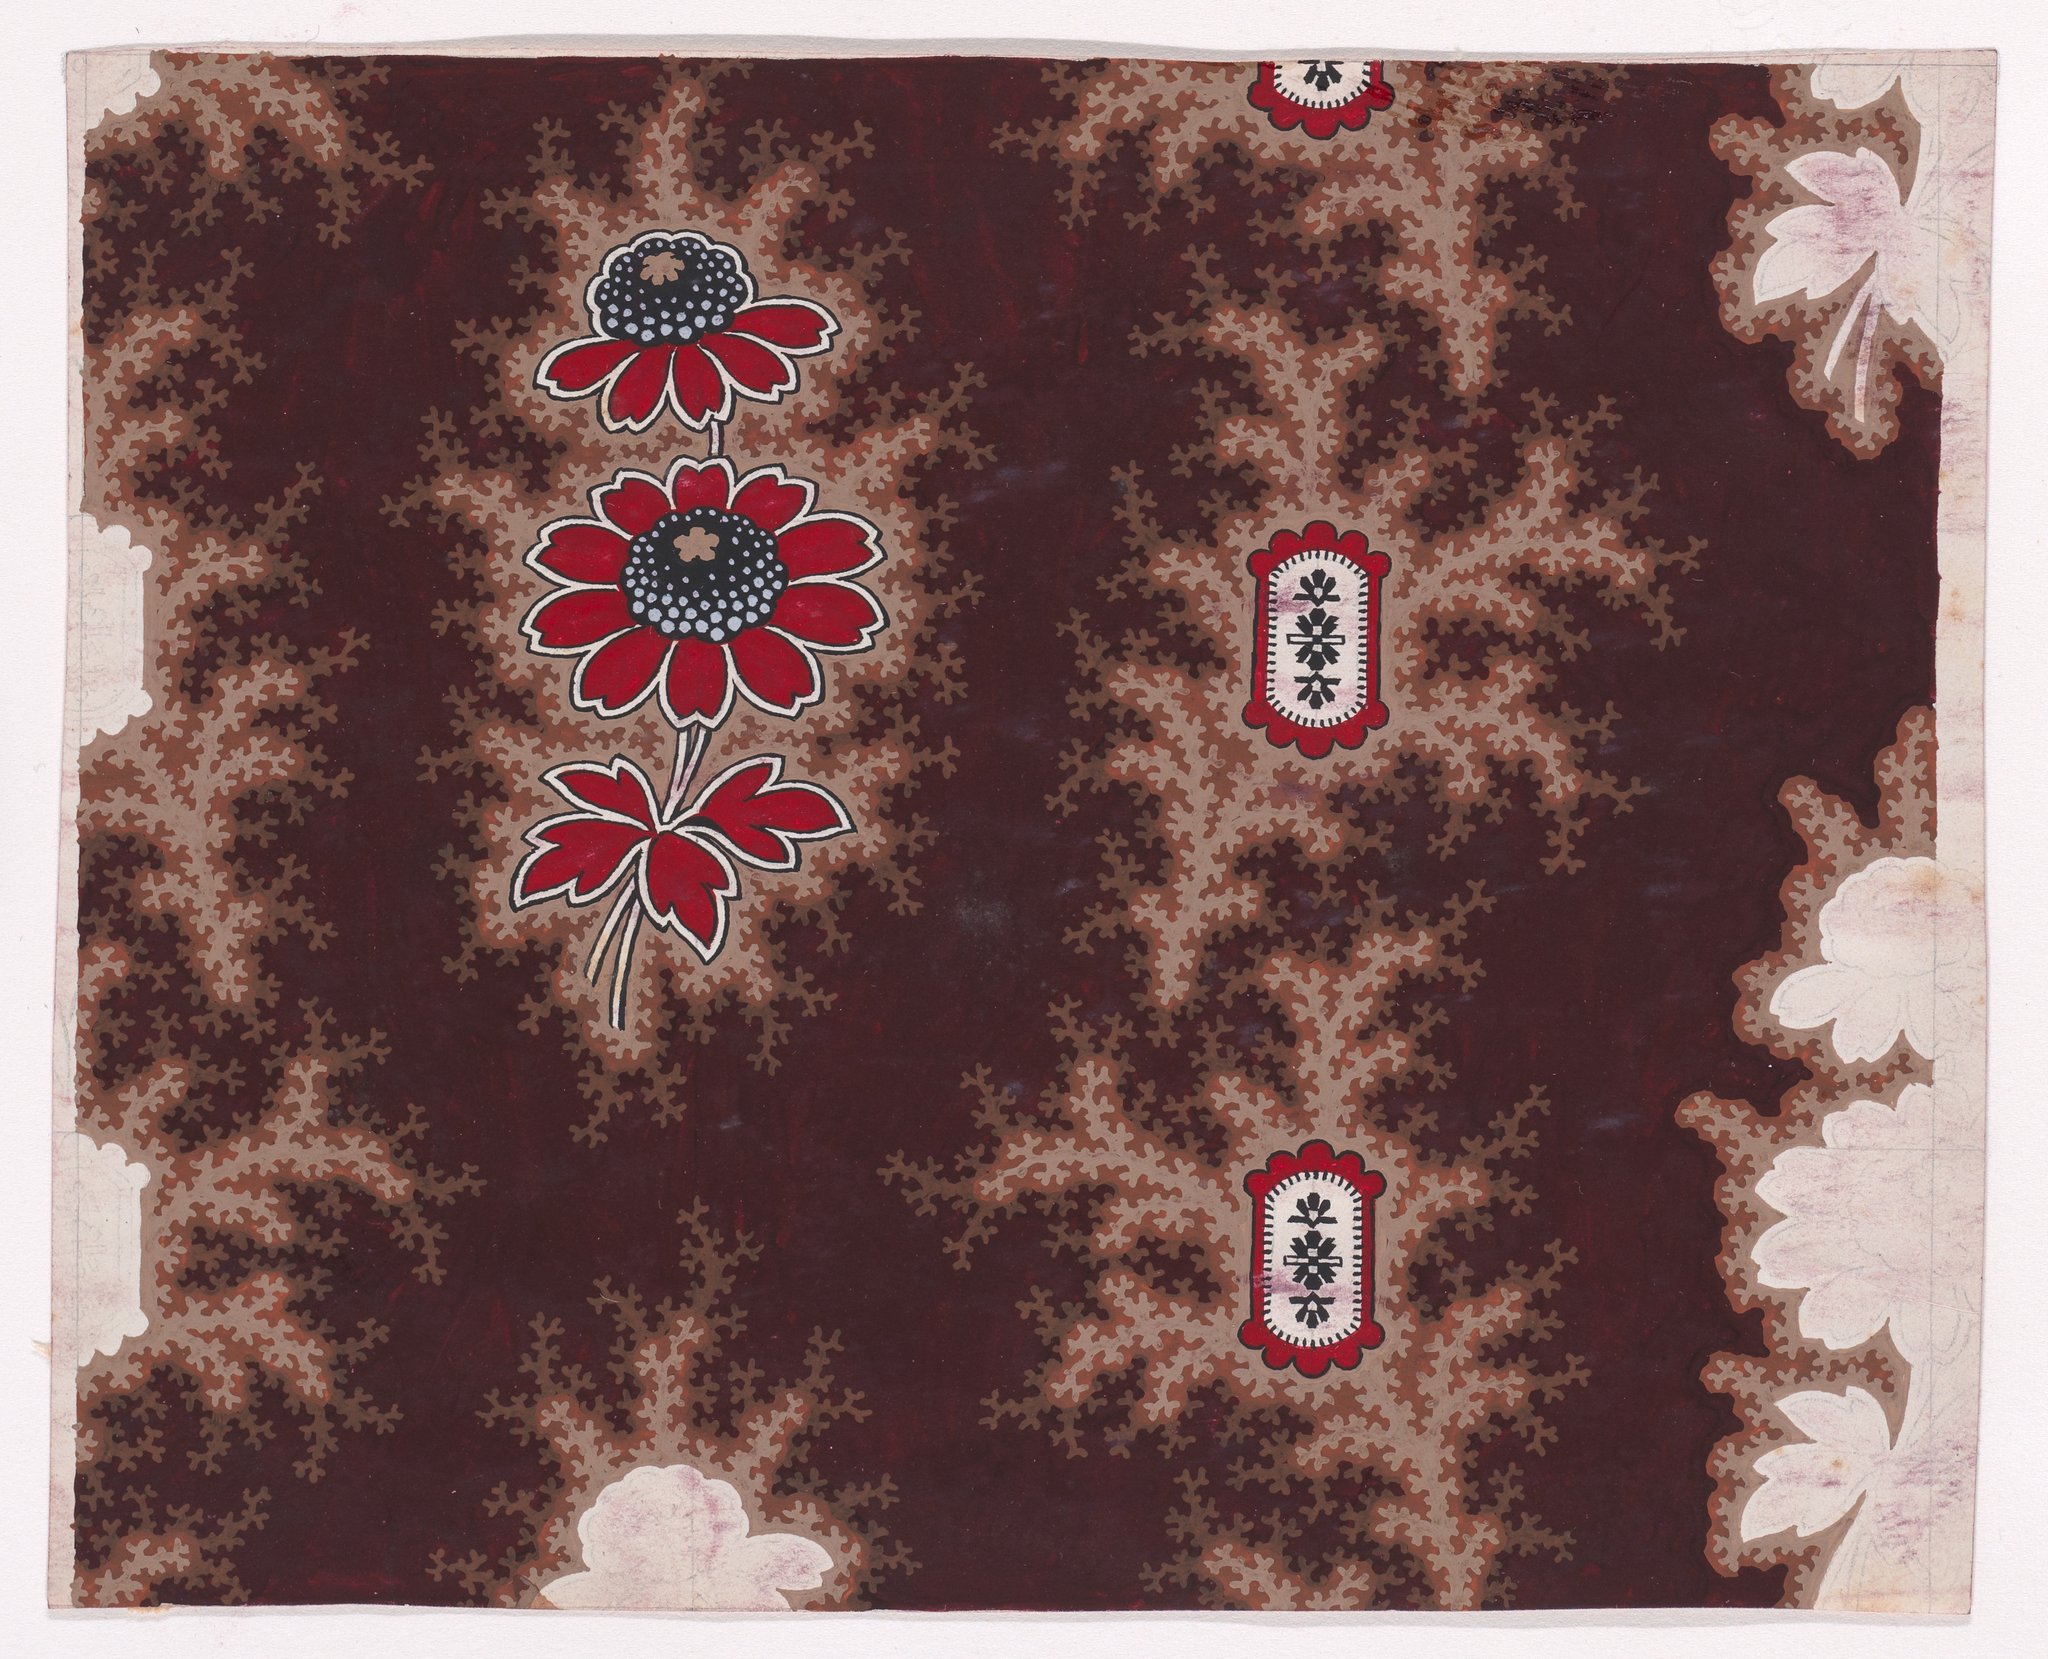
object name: drawing ornament architecture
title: Textile Design with Alternating Vertical Rows of Stylized Flowers with Stems and Leaves with Offsetting Branches Separated by Ornamental Frames Containing Rosettes Flanked by Leaves and with Offsetting Branches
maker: anonymous, alsatian, 19th century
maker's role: artist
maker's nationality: alsatian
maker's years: 1800-1900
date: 1840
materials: gouache